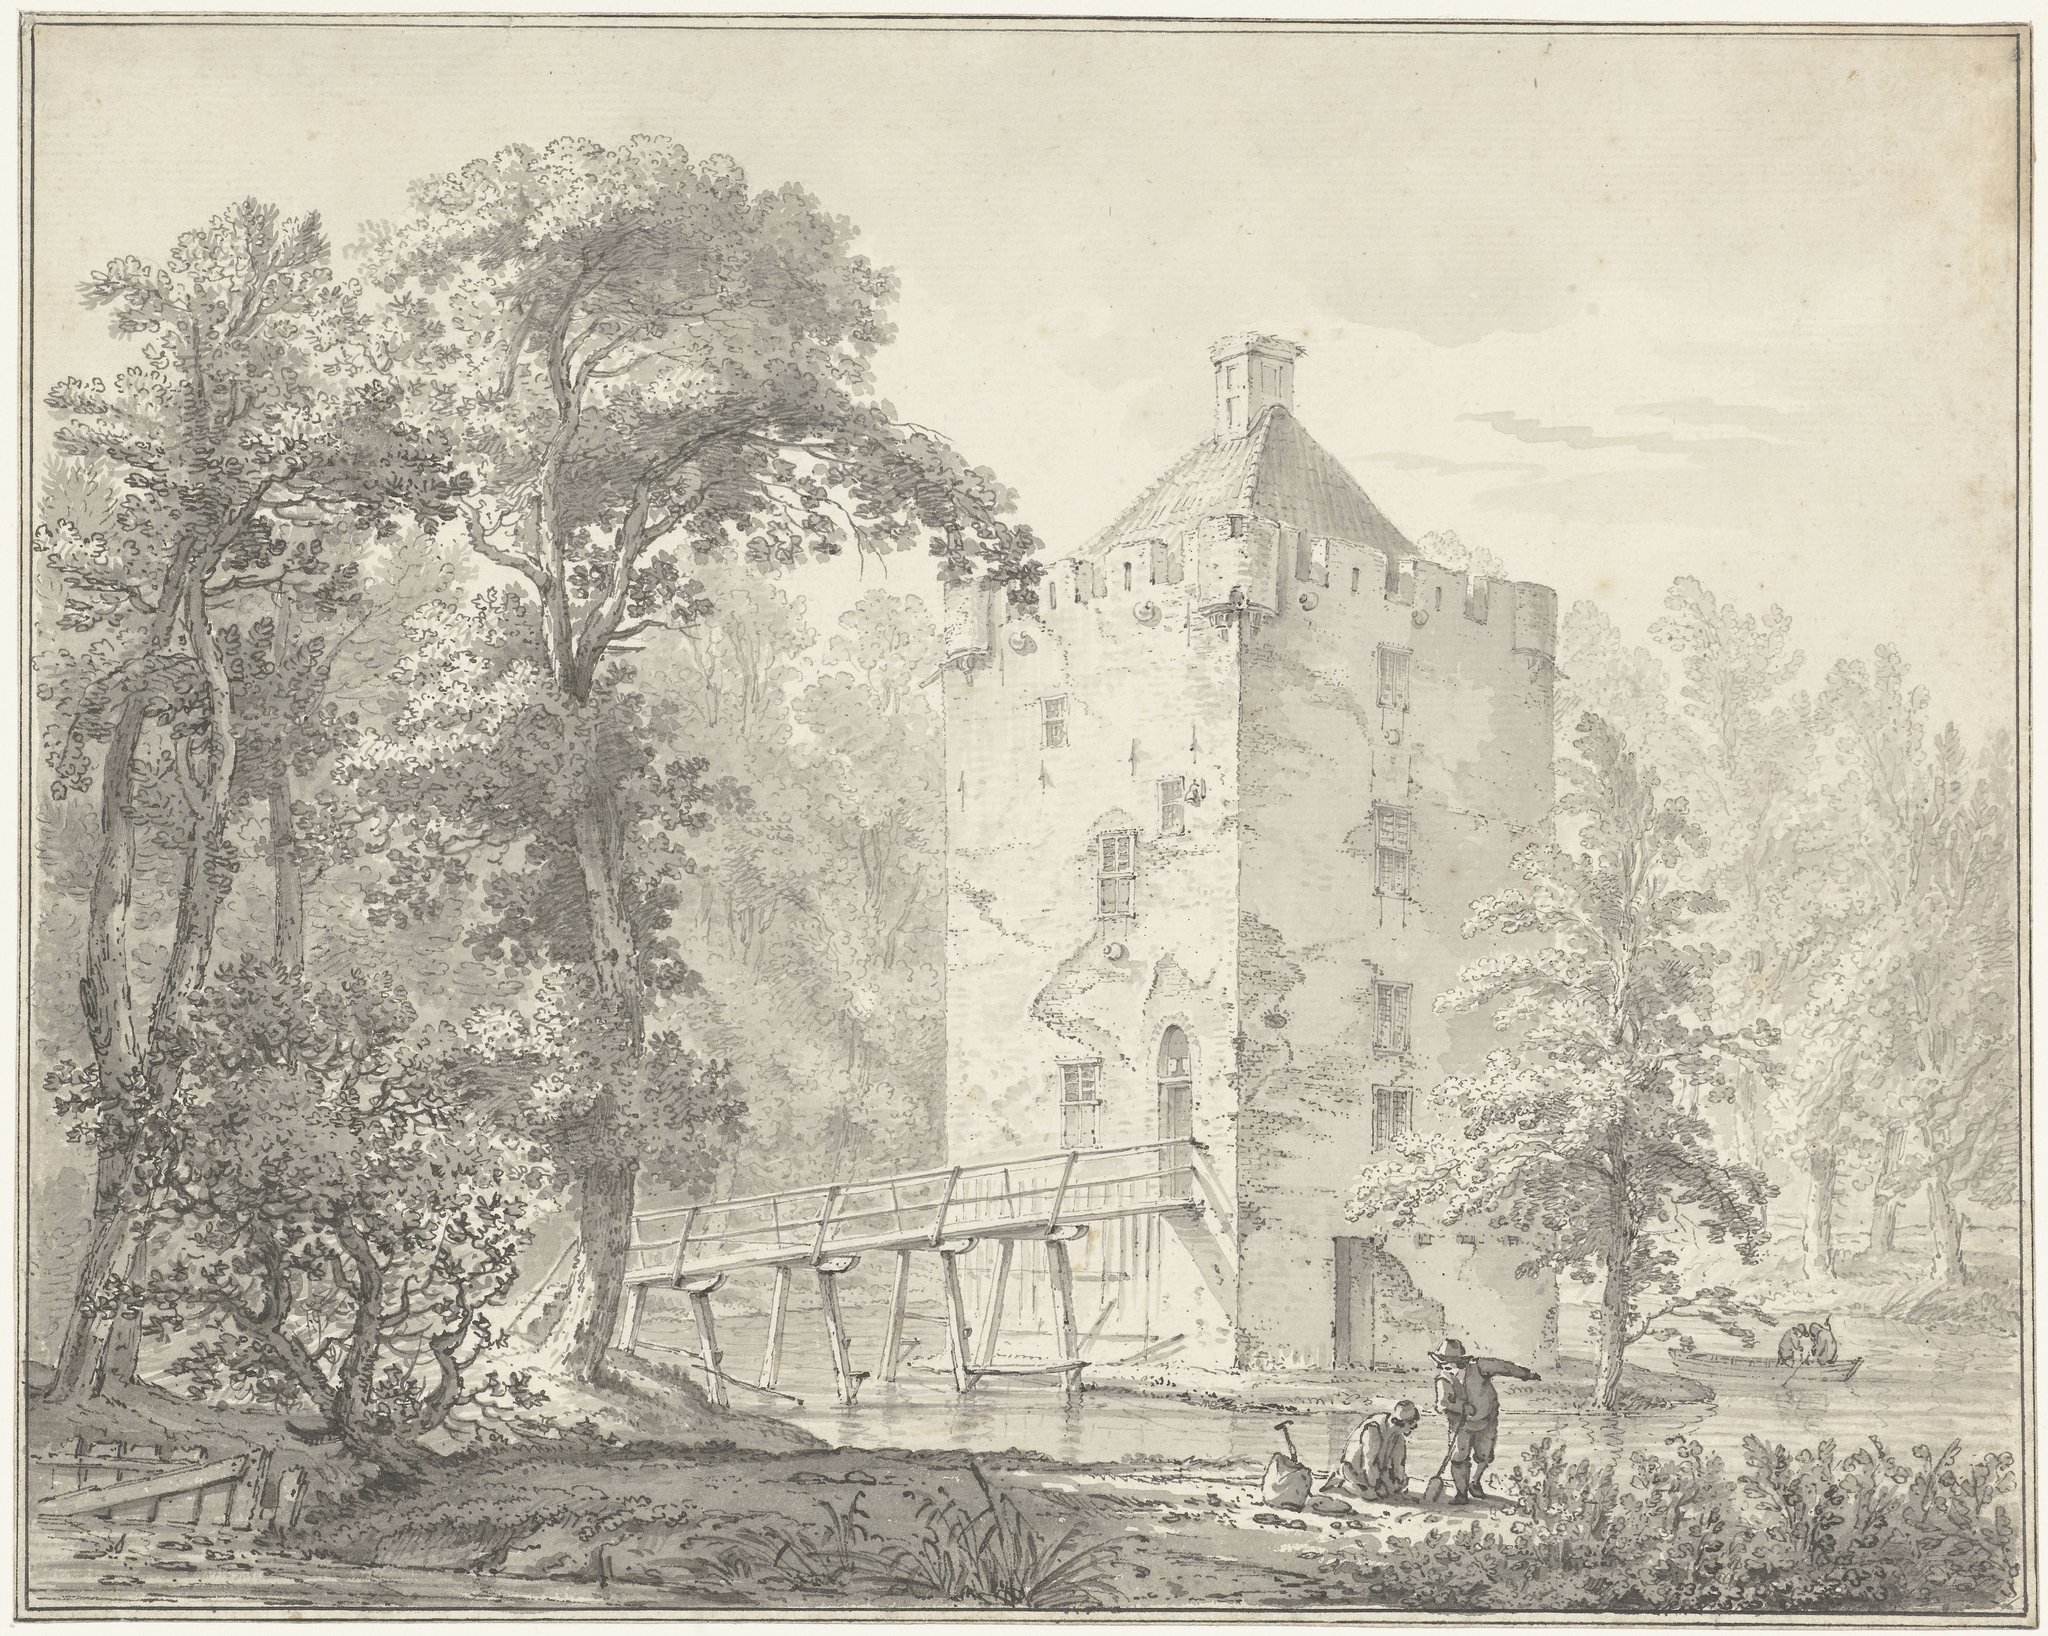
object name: drawing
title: Het huis te Vleuten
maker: egbert marinus frederik d hangest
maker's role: draughtsman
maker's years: 1746-1810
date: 1711-1775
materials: ink, paper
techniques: brush, pen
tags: castle